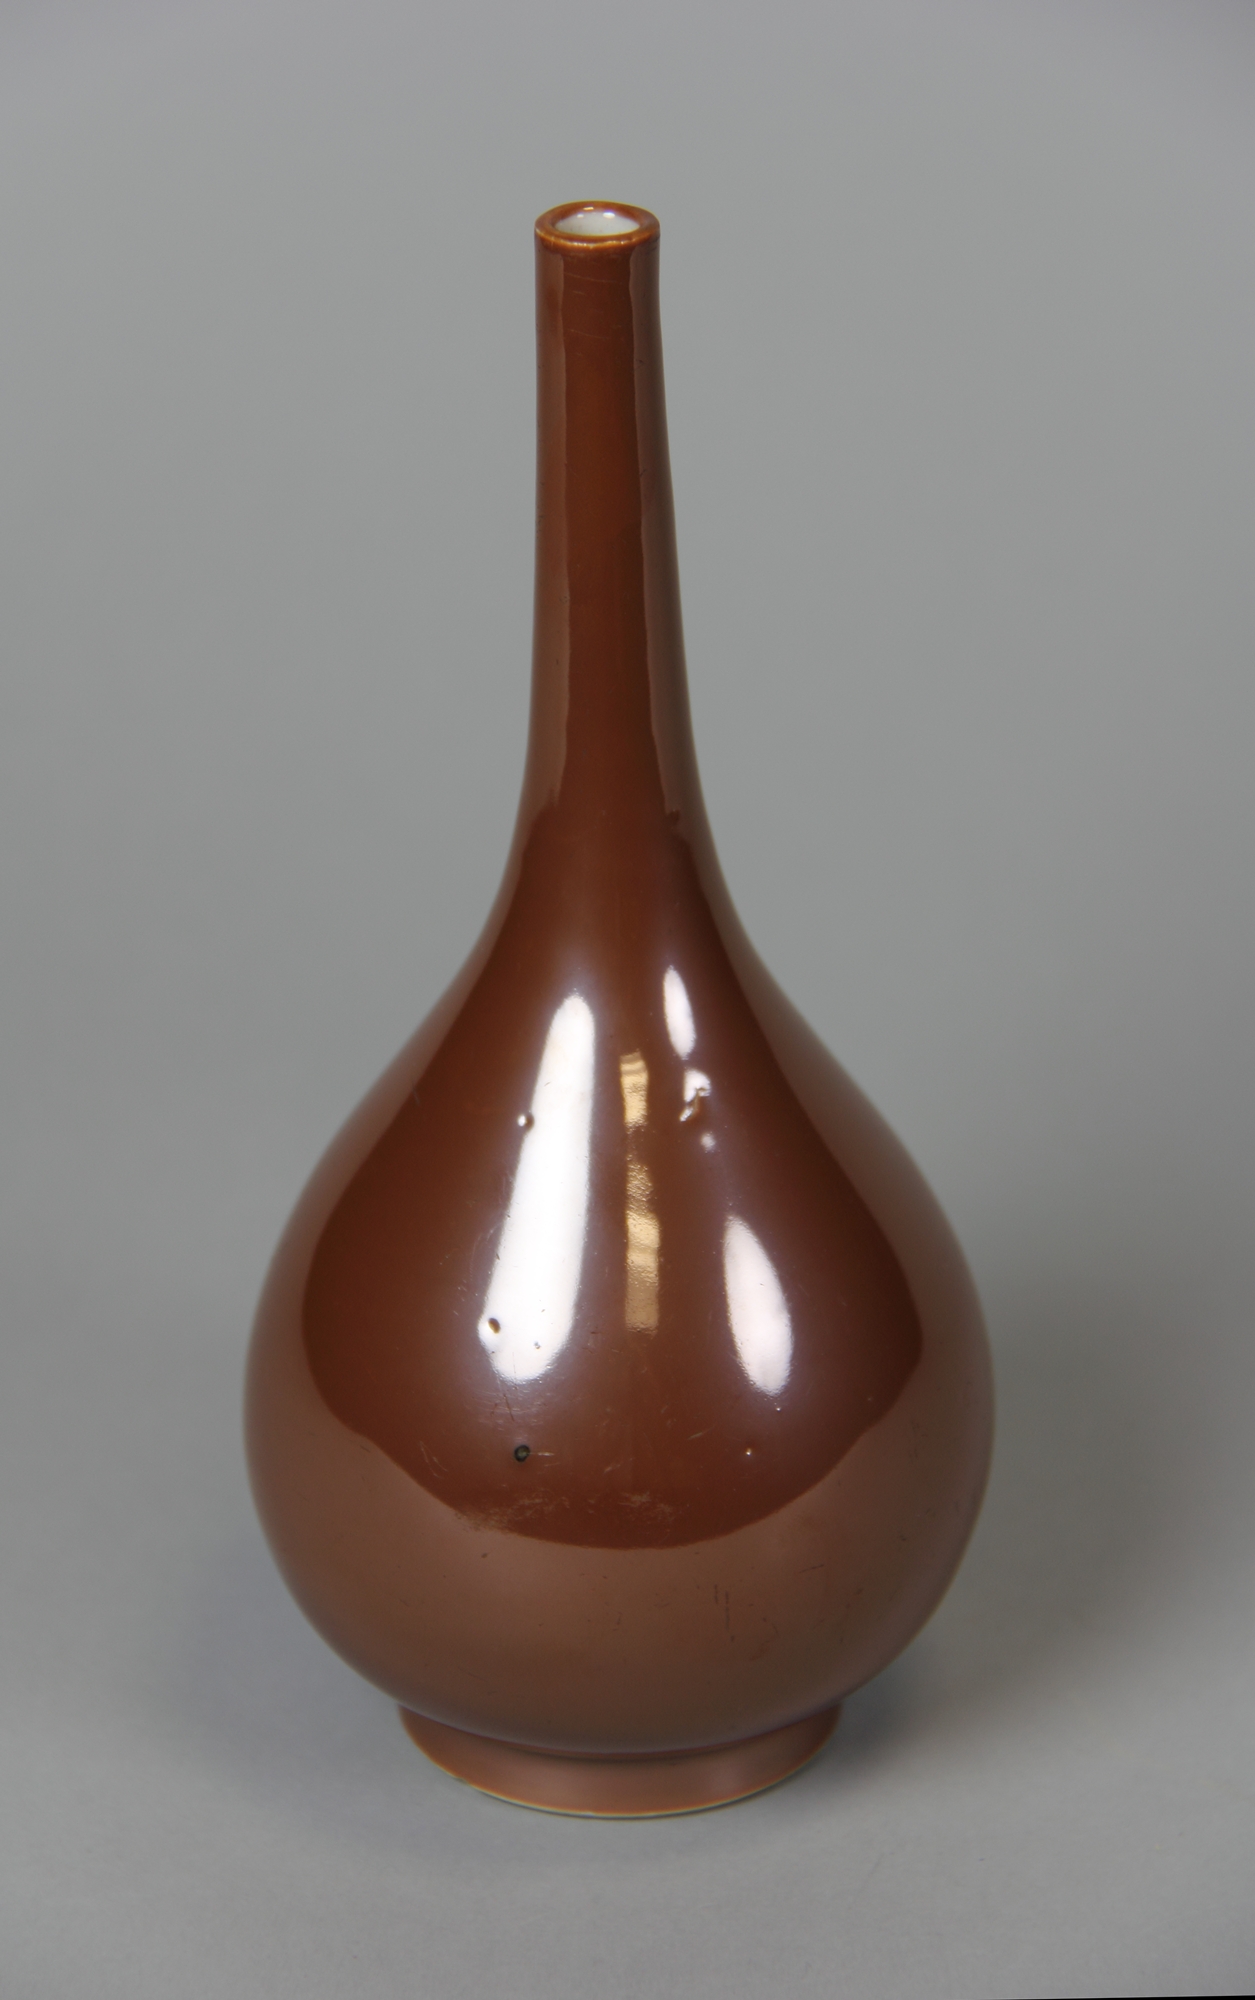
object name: bottle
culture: chinese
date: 1701-1733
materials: glaze, porcelain